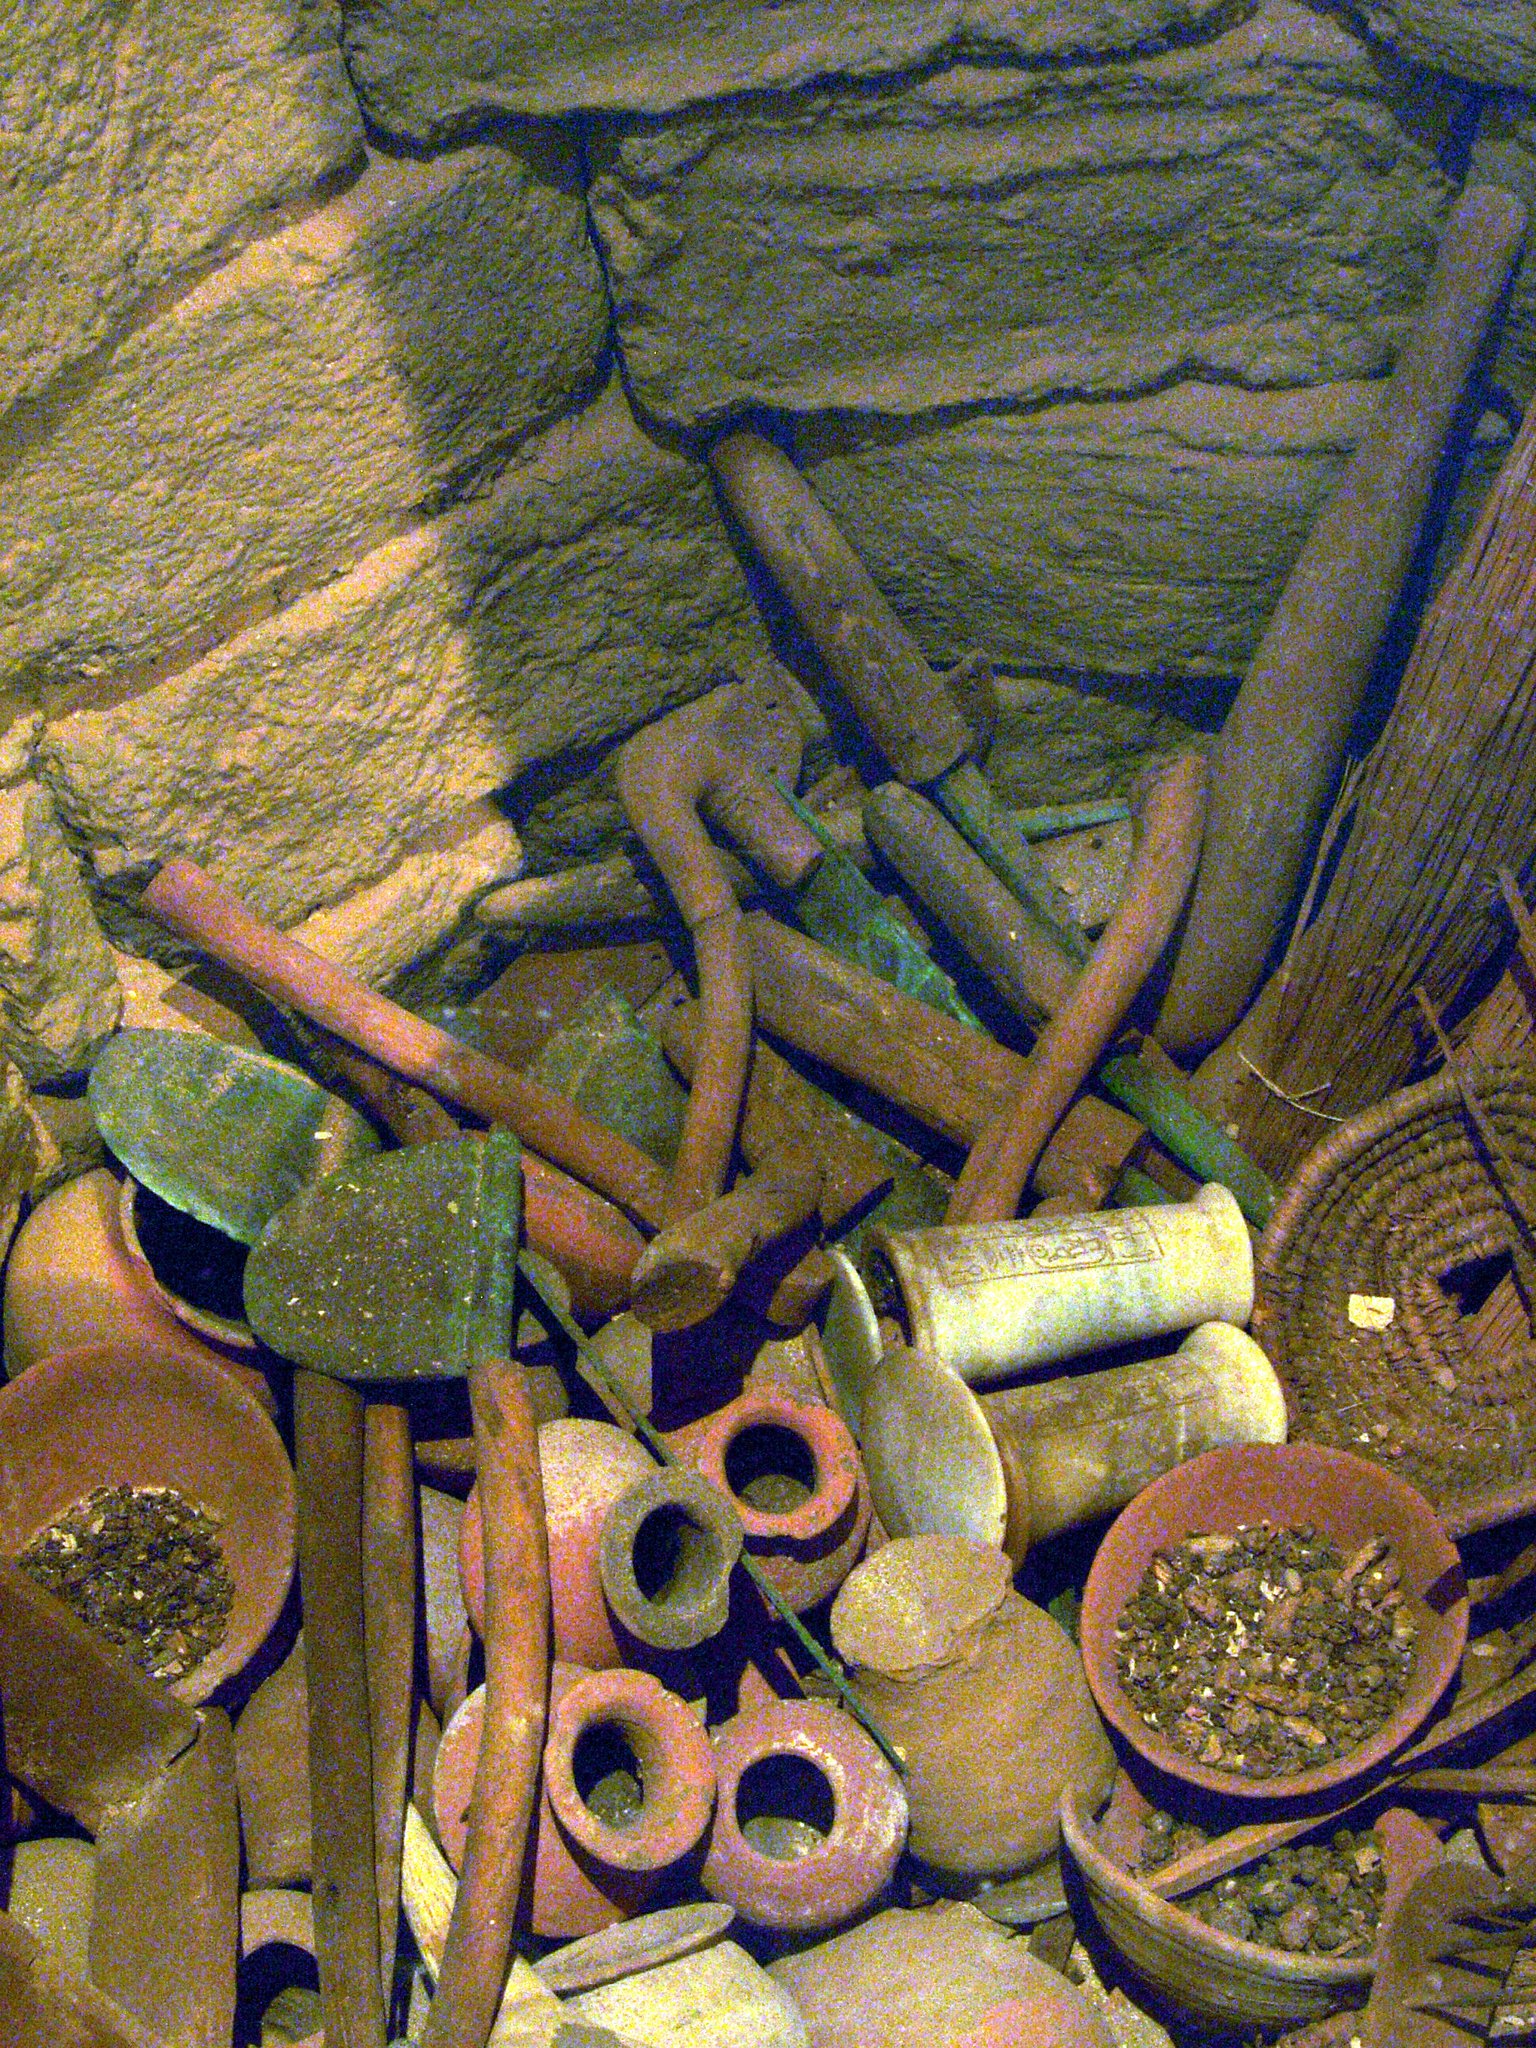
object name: foundation deposit pit, hatshepsut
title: Reconstruction of a Foundation Deposit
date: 1479-1458 BCE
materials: bronze, copper alloy, leather, pottery, stone, wood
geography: egypt